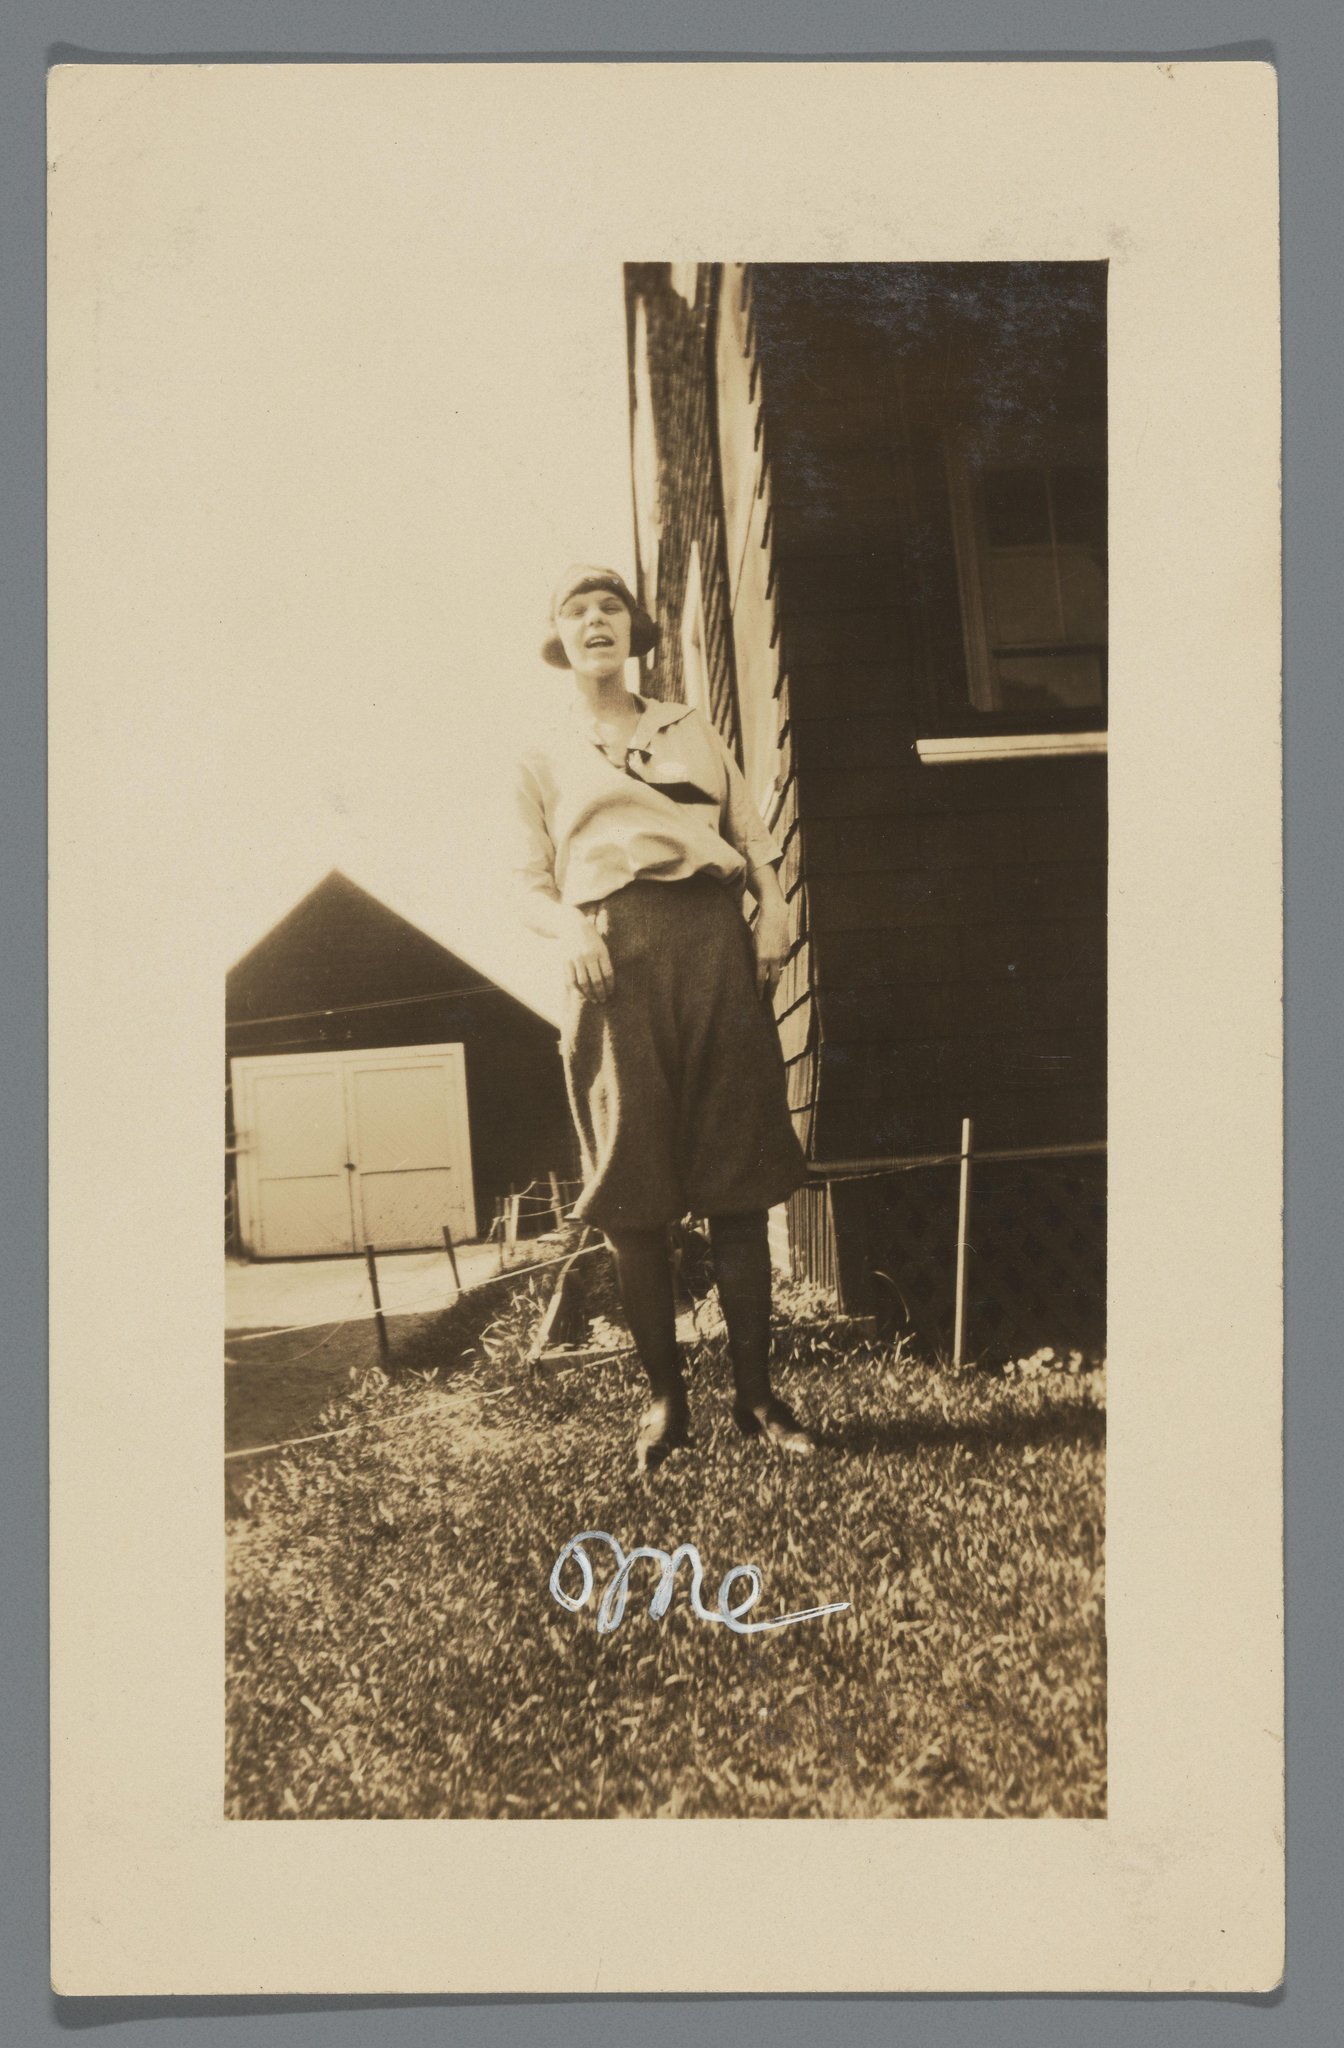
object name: photograph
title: Vrouw staand bij een huis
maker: Anonymous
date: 1925-1940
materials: paper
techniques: gelatin silver print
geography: united states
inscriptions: inscription: ‘Me’